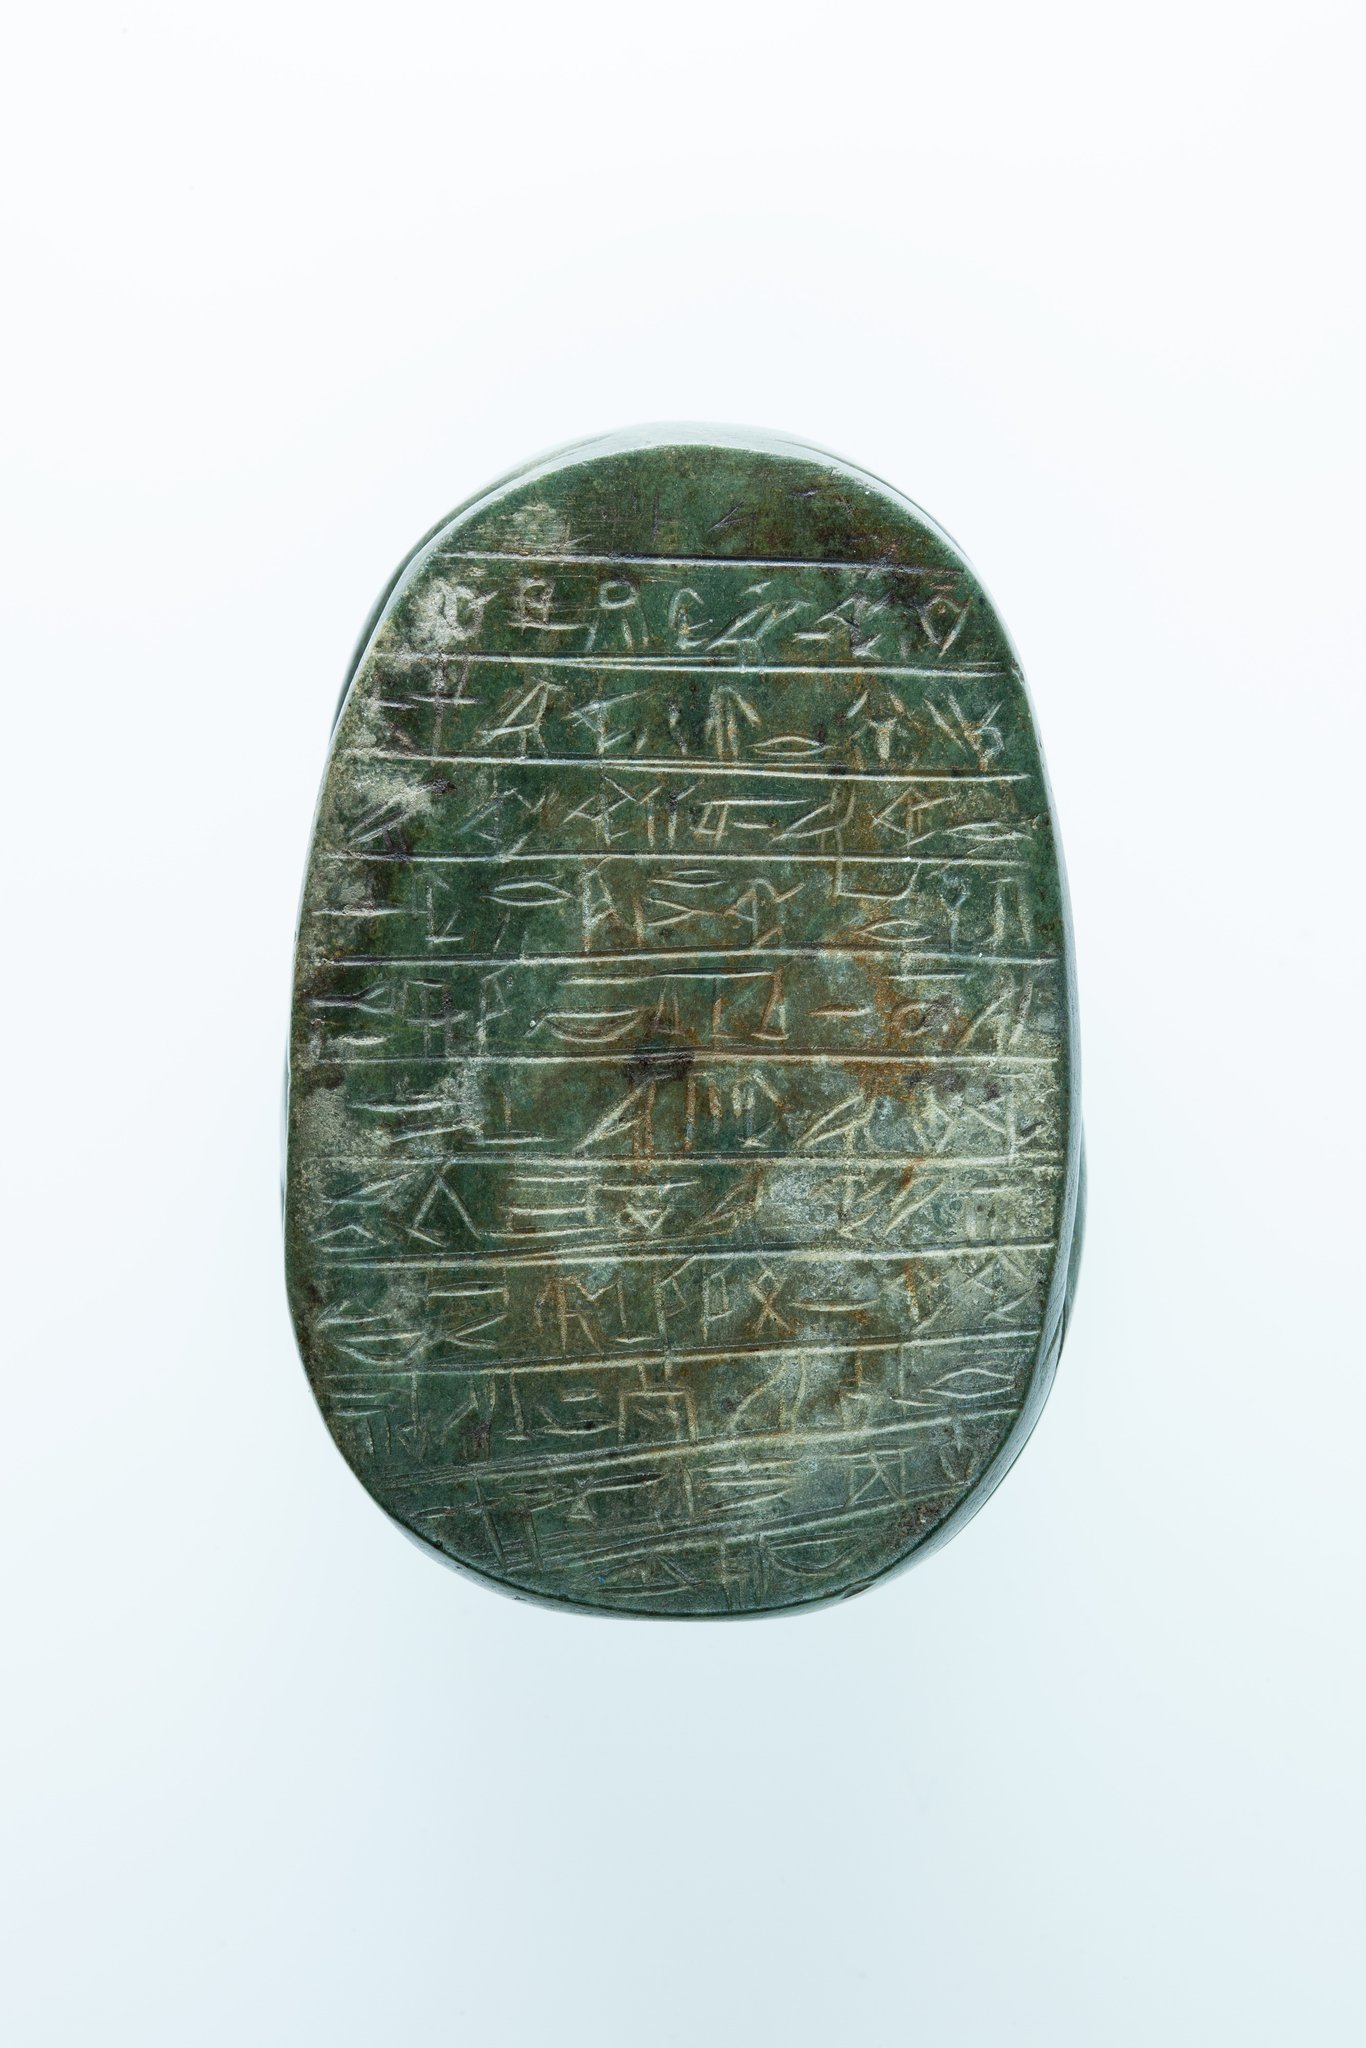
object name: heart scarab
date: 1550-1186 BCE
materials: stone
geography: egypt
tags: hieroglyphs,scarabs